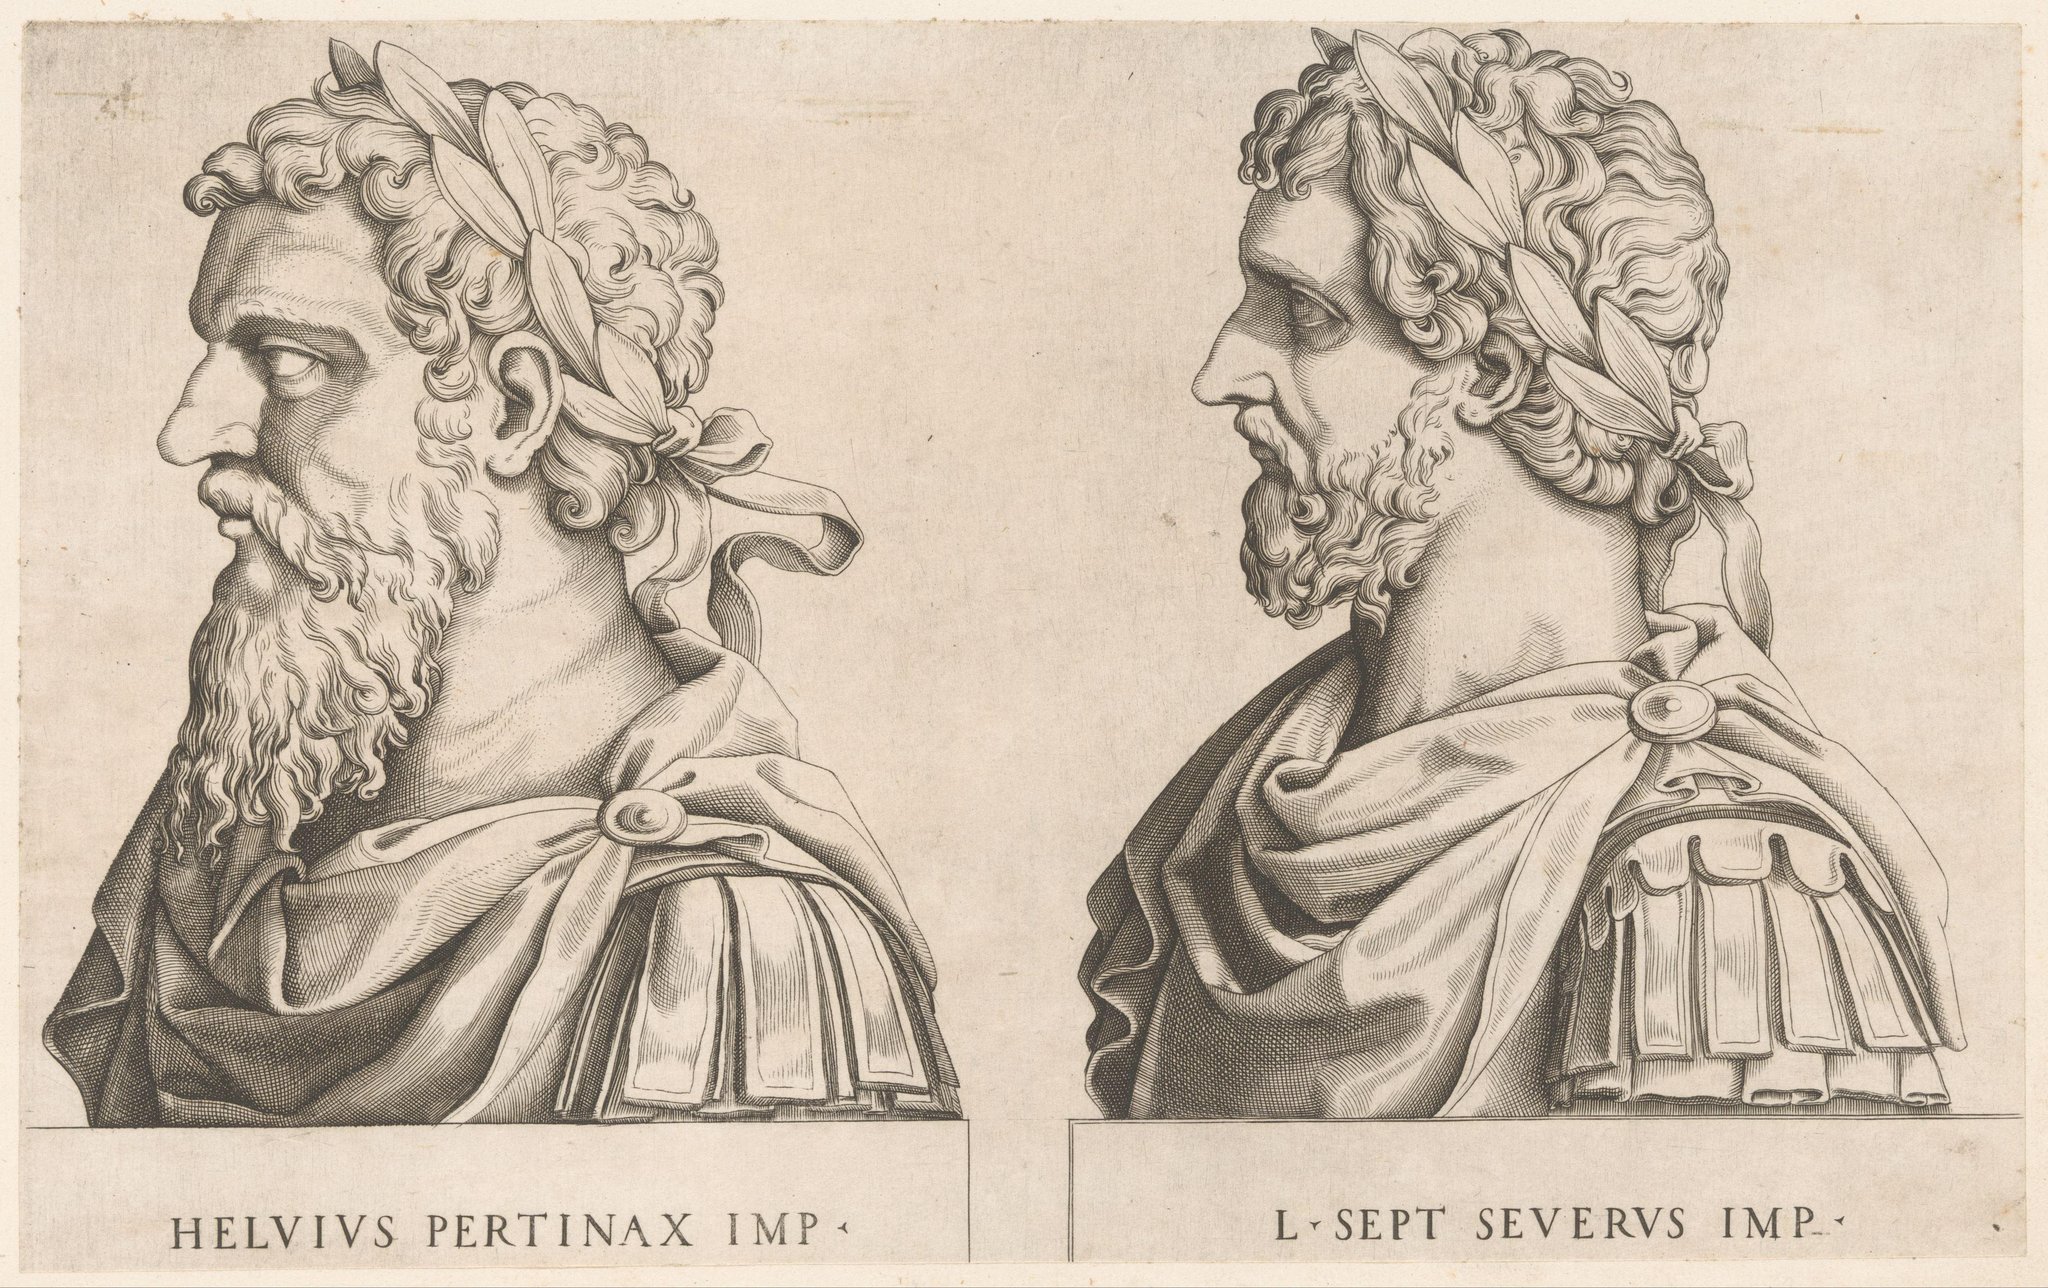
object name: print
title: Portretbustes van Romeinse keizers Pertinax en Septimius Severus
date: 1510-1562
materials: paper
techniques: engraving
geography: rome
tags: historical persons, ruler, sovereign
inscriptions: collector's mark: Lugt 11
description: Deze prent is samen met RP-P-H-H-258 op één opzetvel geplakt.